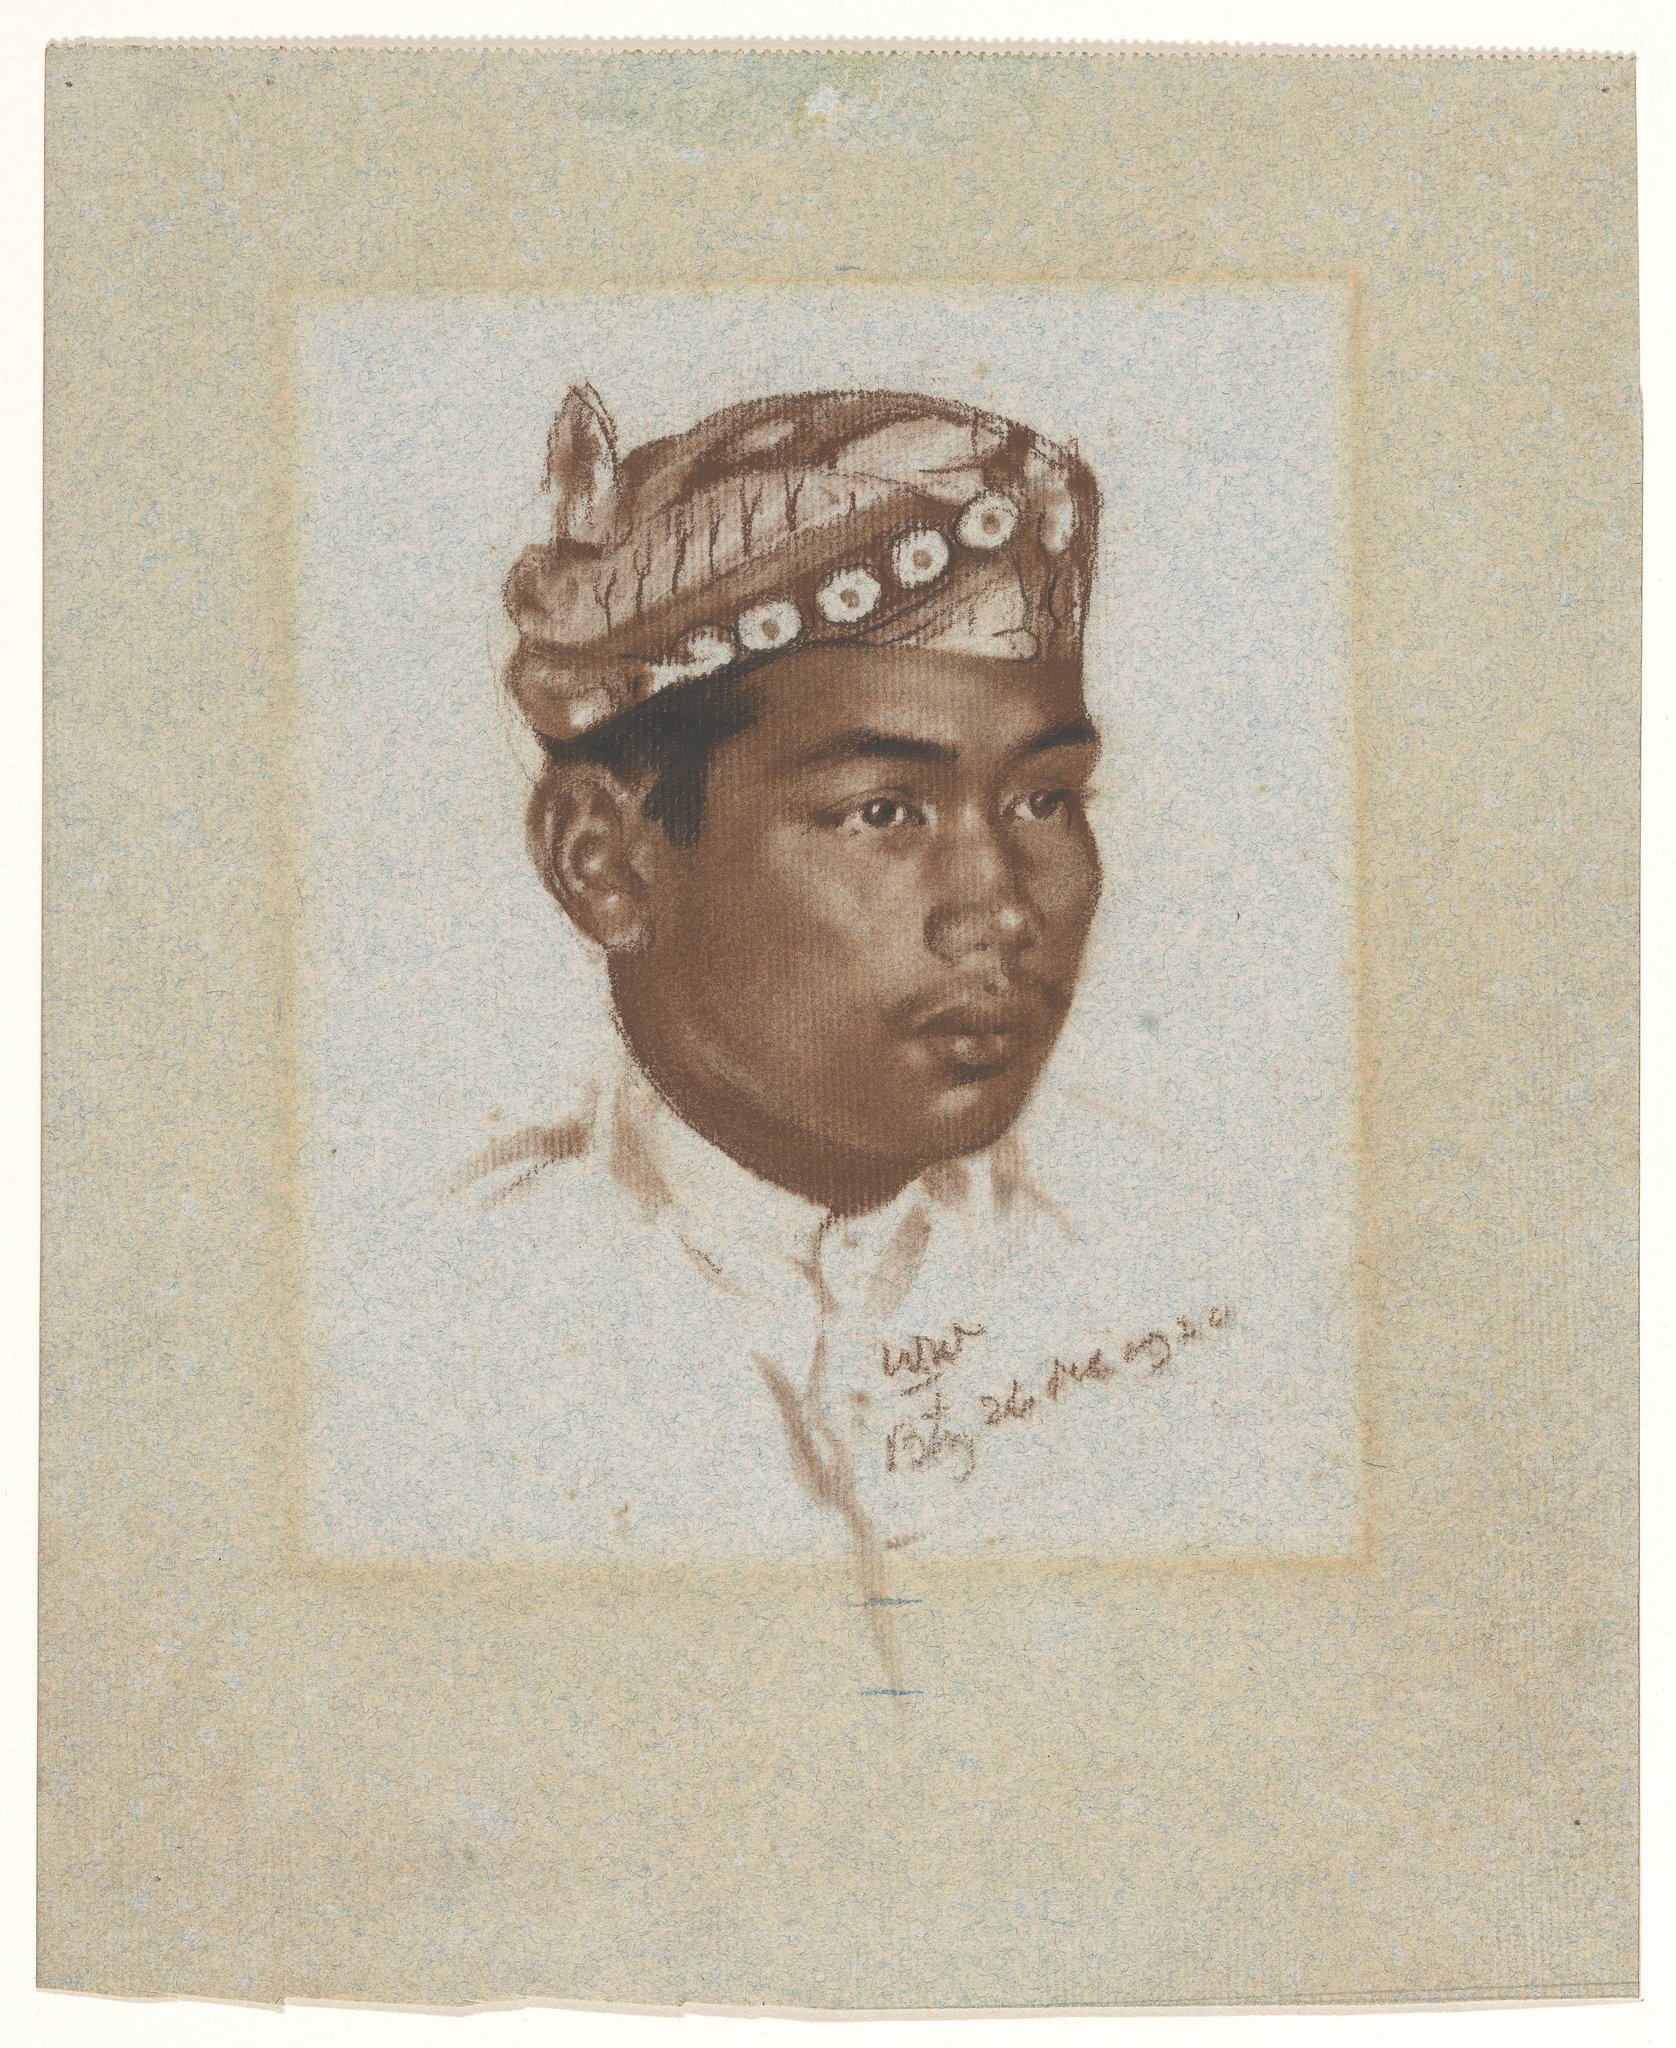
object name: drawing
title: Portret van een Soendanese man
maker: willem witsen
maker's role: draughtsman, painter, print maker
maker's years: 1860-1923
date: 1920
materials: chalk, paper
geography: buitenzorg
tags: anonymous historical person portrayed alone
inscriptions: date: ‘1920’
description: Deze man was als bediende werkzaam in Hotel Bellevue, waar Willem Witsen verbleef toen hij in Buitenzorg was.